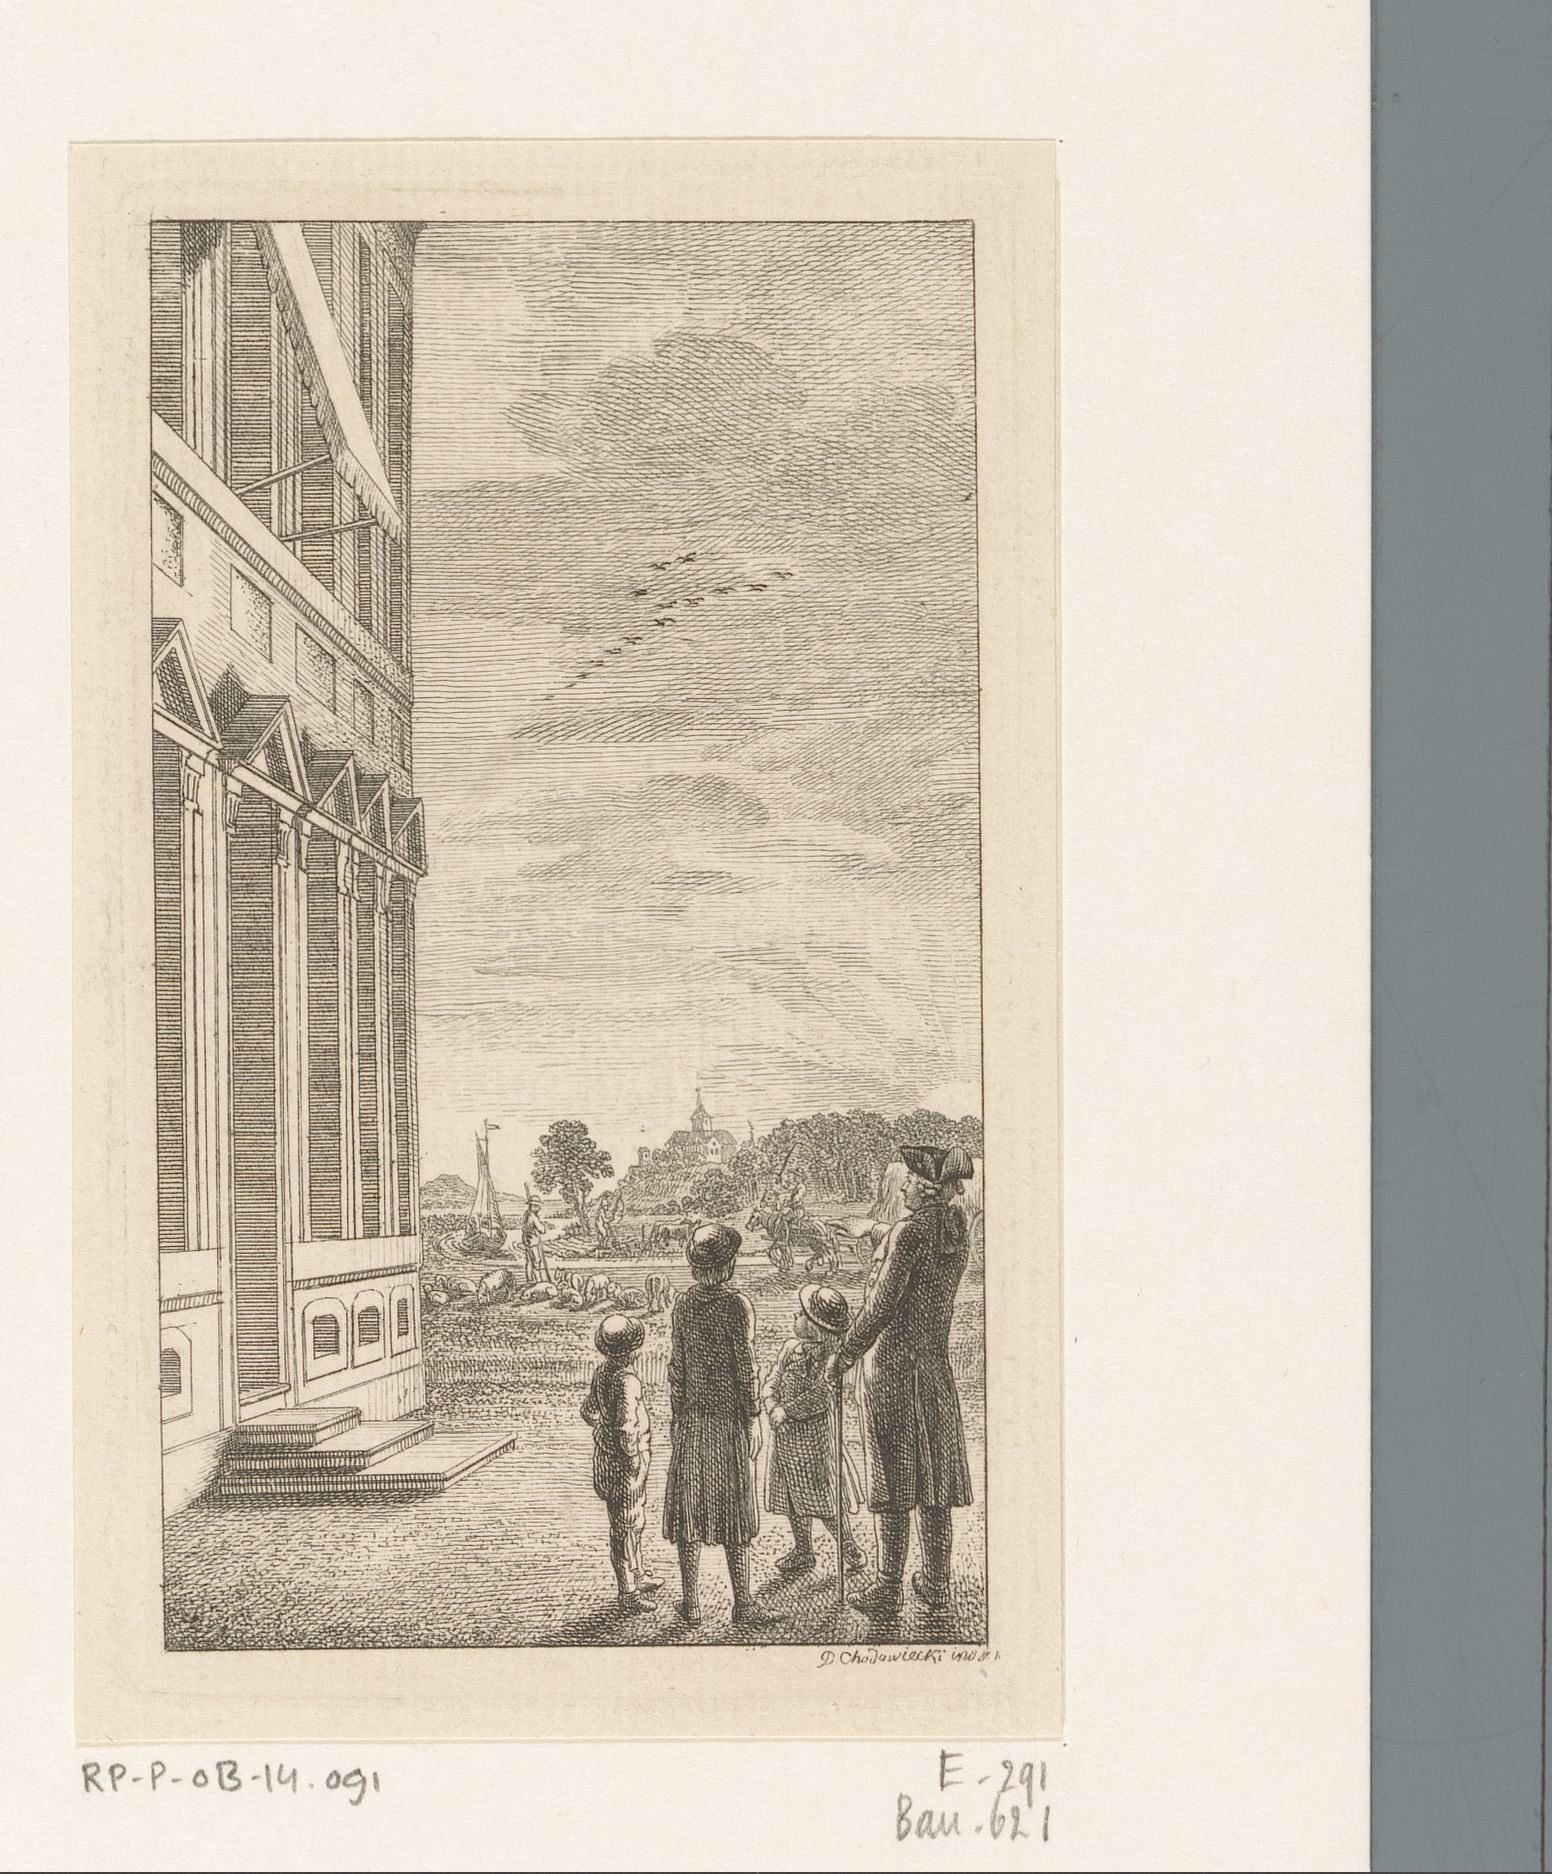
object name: print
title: Leraar met drie kinderen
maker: daniel nikolaus chodowiecki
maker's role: draughtsman, print maker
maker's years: 1726-1801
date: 1779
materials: paper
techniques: etching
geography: berlin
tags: teacher and pupil, façade (of house or building)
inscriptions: collector's mark: Lugt 2228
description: Deze prent maakt deel uit van een serie van acht prenten. Deze prenten zijn gebruikt in: Schulz, Johann Michael Friedrich. Elementarbuch der lateinischen Sprache. Berlijn: August Mylius, 1779, 2 dln.